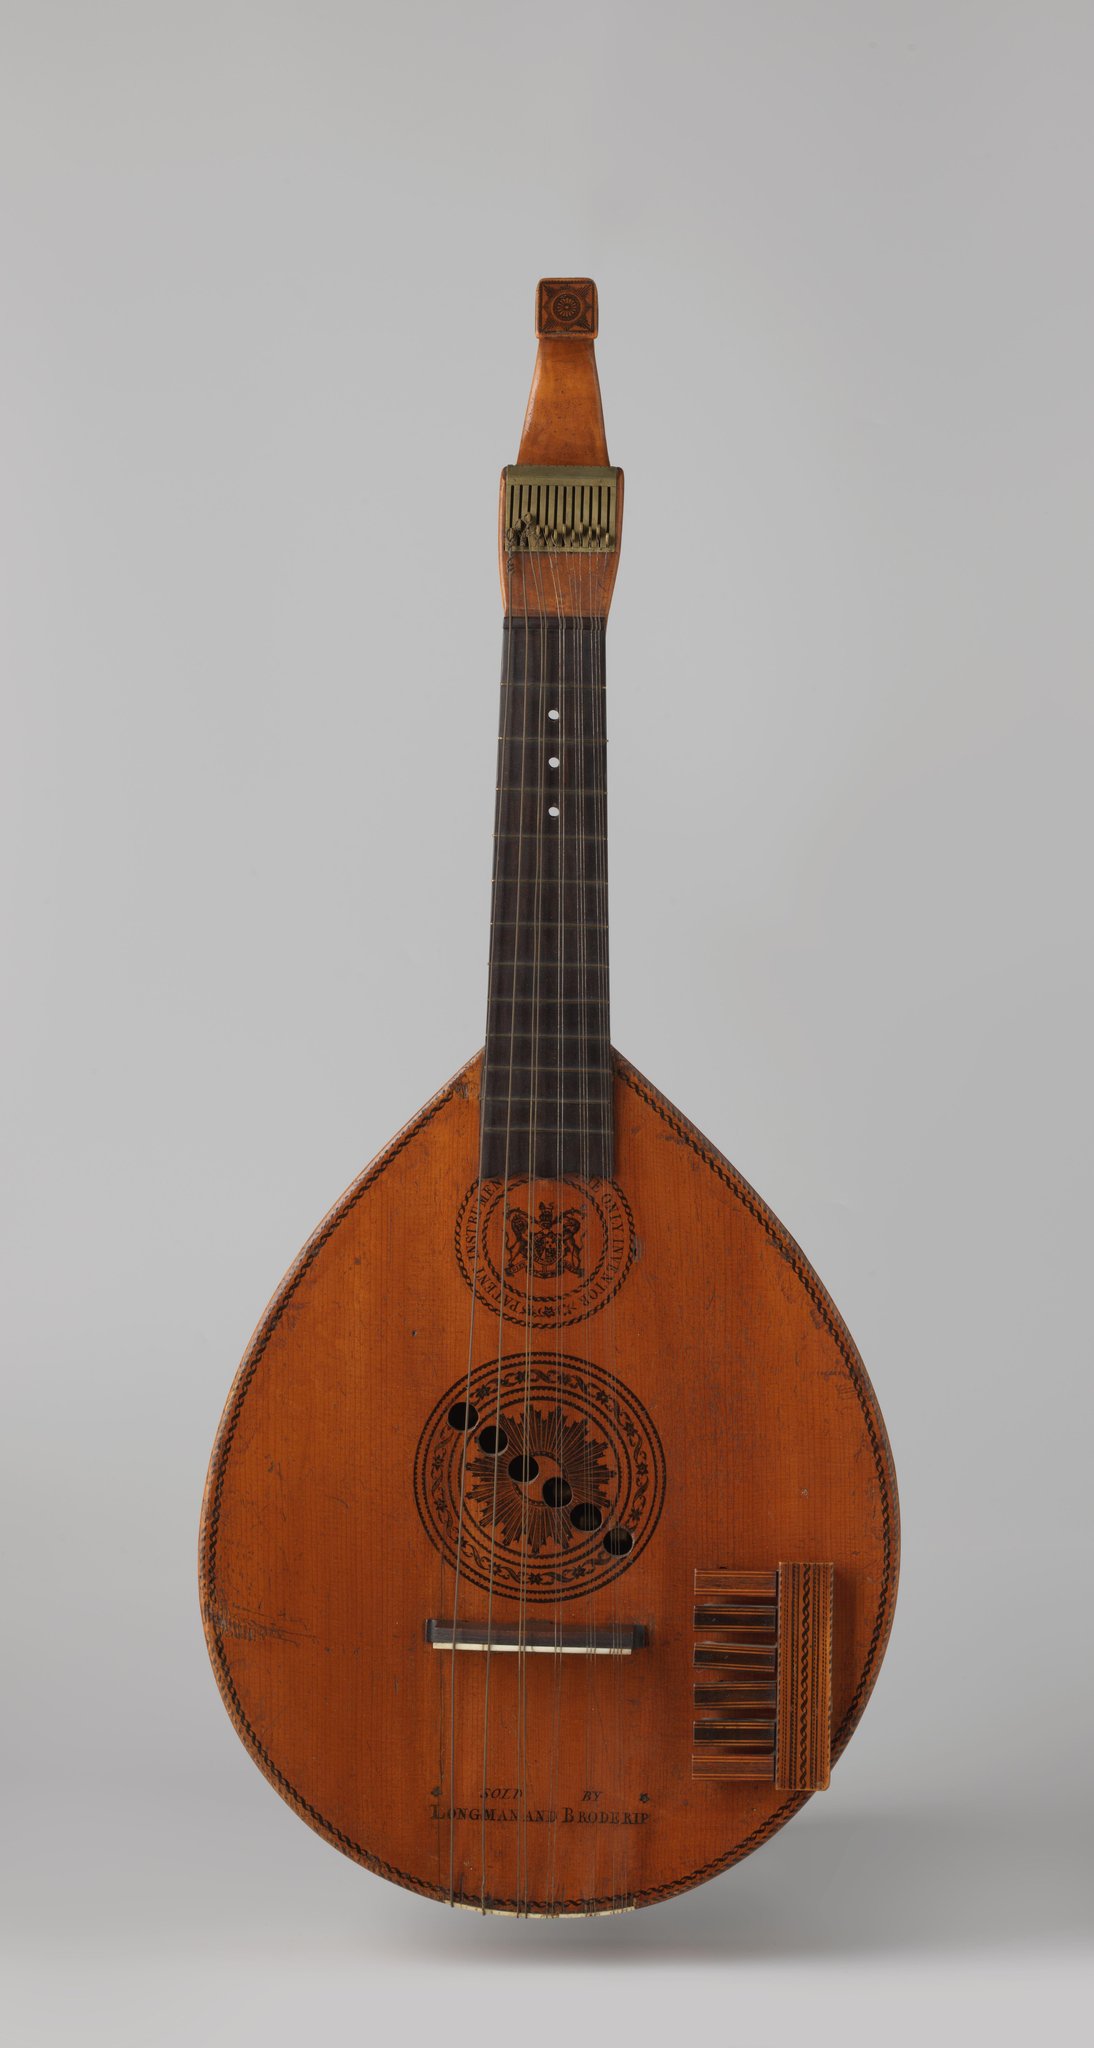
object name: musical instrument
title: Keyed guitar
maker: christian claus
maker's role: musical instrument maker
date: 1785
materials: bone, wood, metal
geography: london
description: In the late 18th century, mass-production methods made instruments accessible to a large audience. This guitar is an example of this development and was conceived as a portable equivalent of a keyboard instrument for fashionable ladies. Its piano-key mechanism activates small hammers that strike the strings. This simplified the playing technique and protected the women’s fingertips.